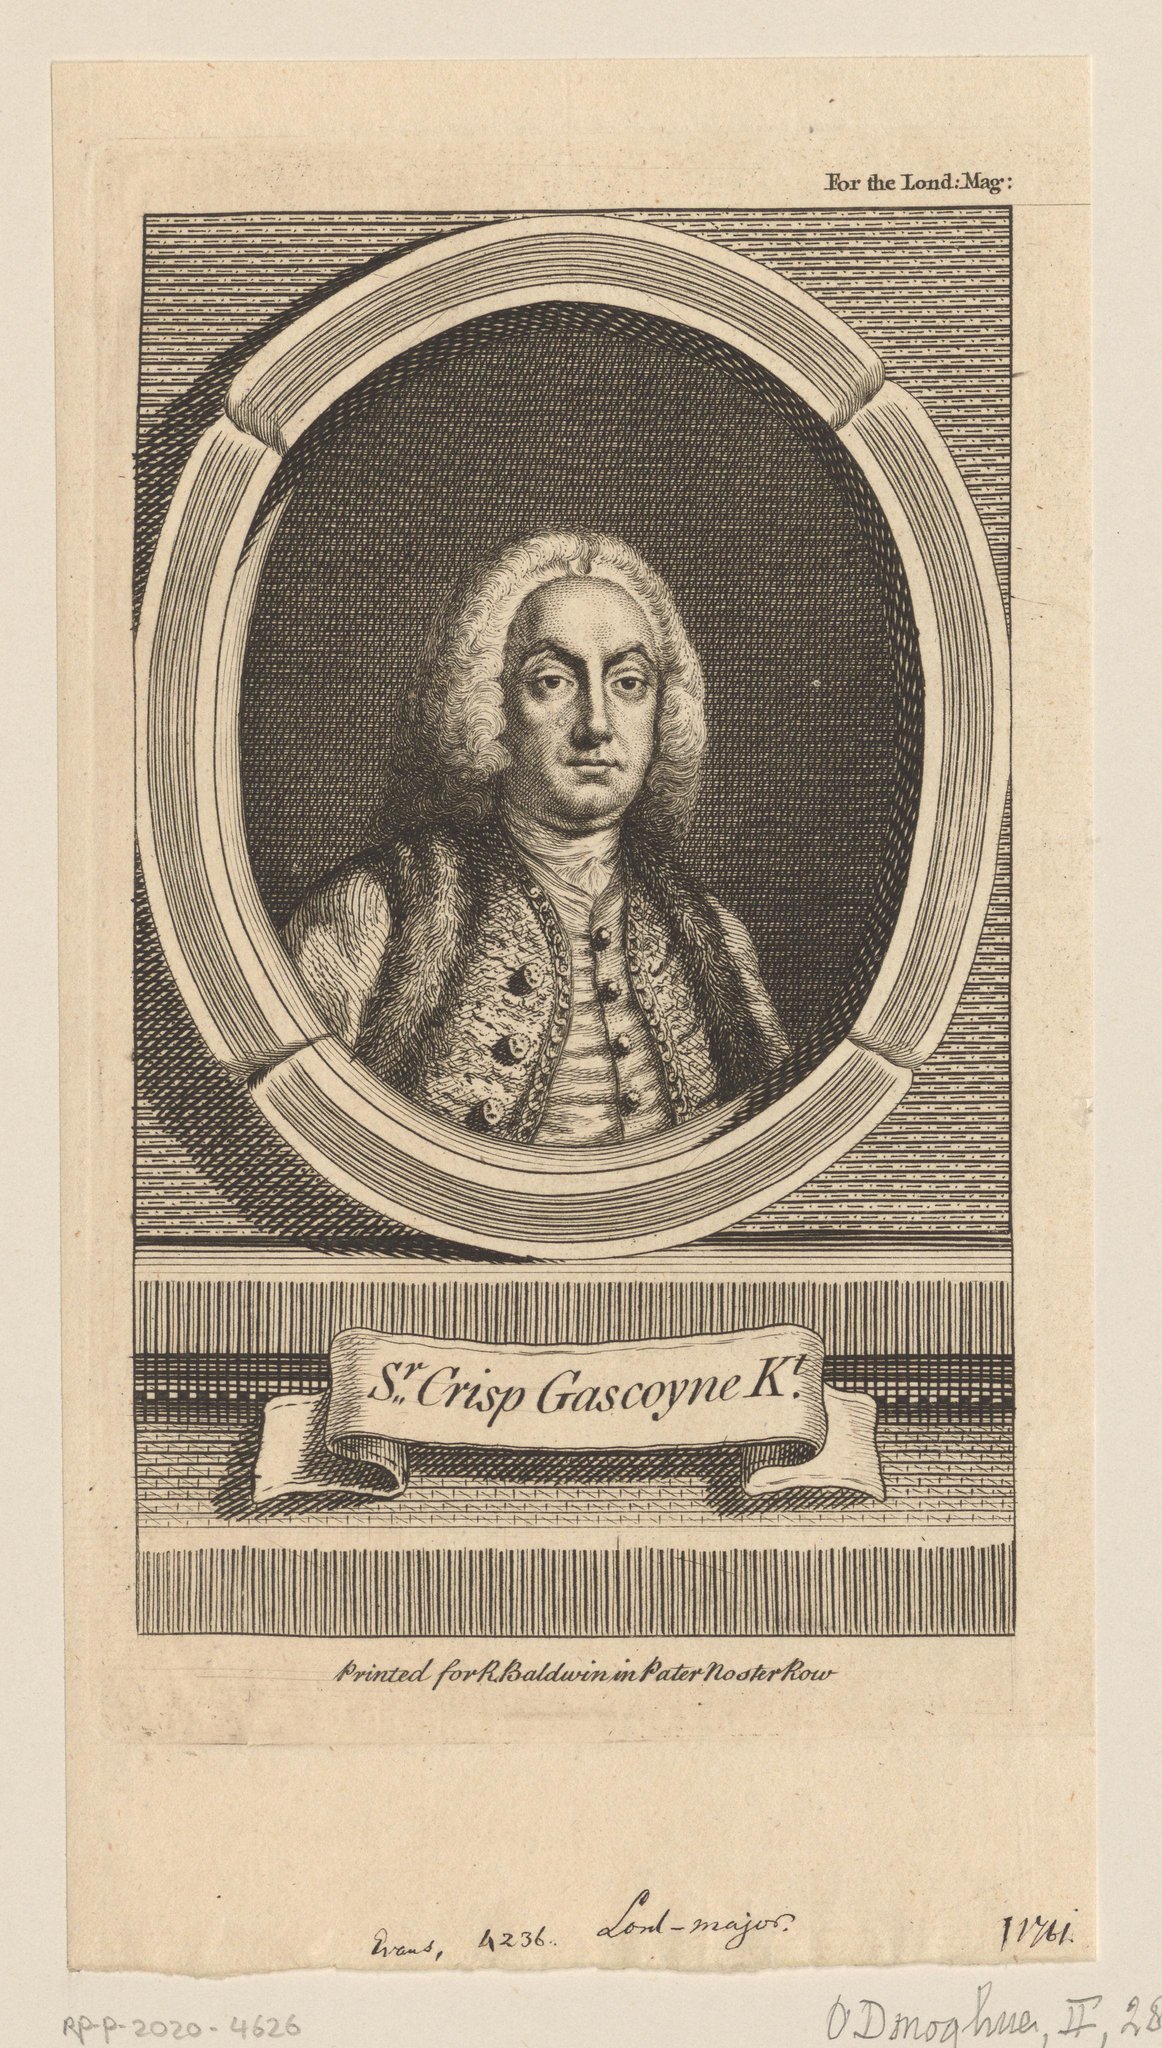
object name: print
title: Portret van Crisp Gascoyne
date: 1747-1783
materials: paper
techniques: engraving, etching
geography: london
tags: mayor, burgomaster, historical persons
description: Prent uit: The London magazine, or, Gentleman's monthly intelligencer [1747-1783].